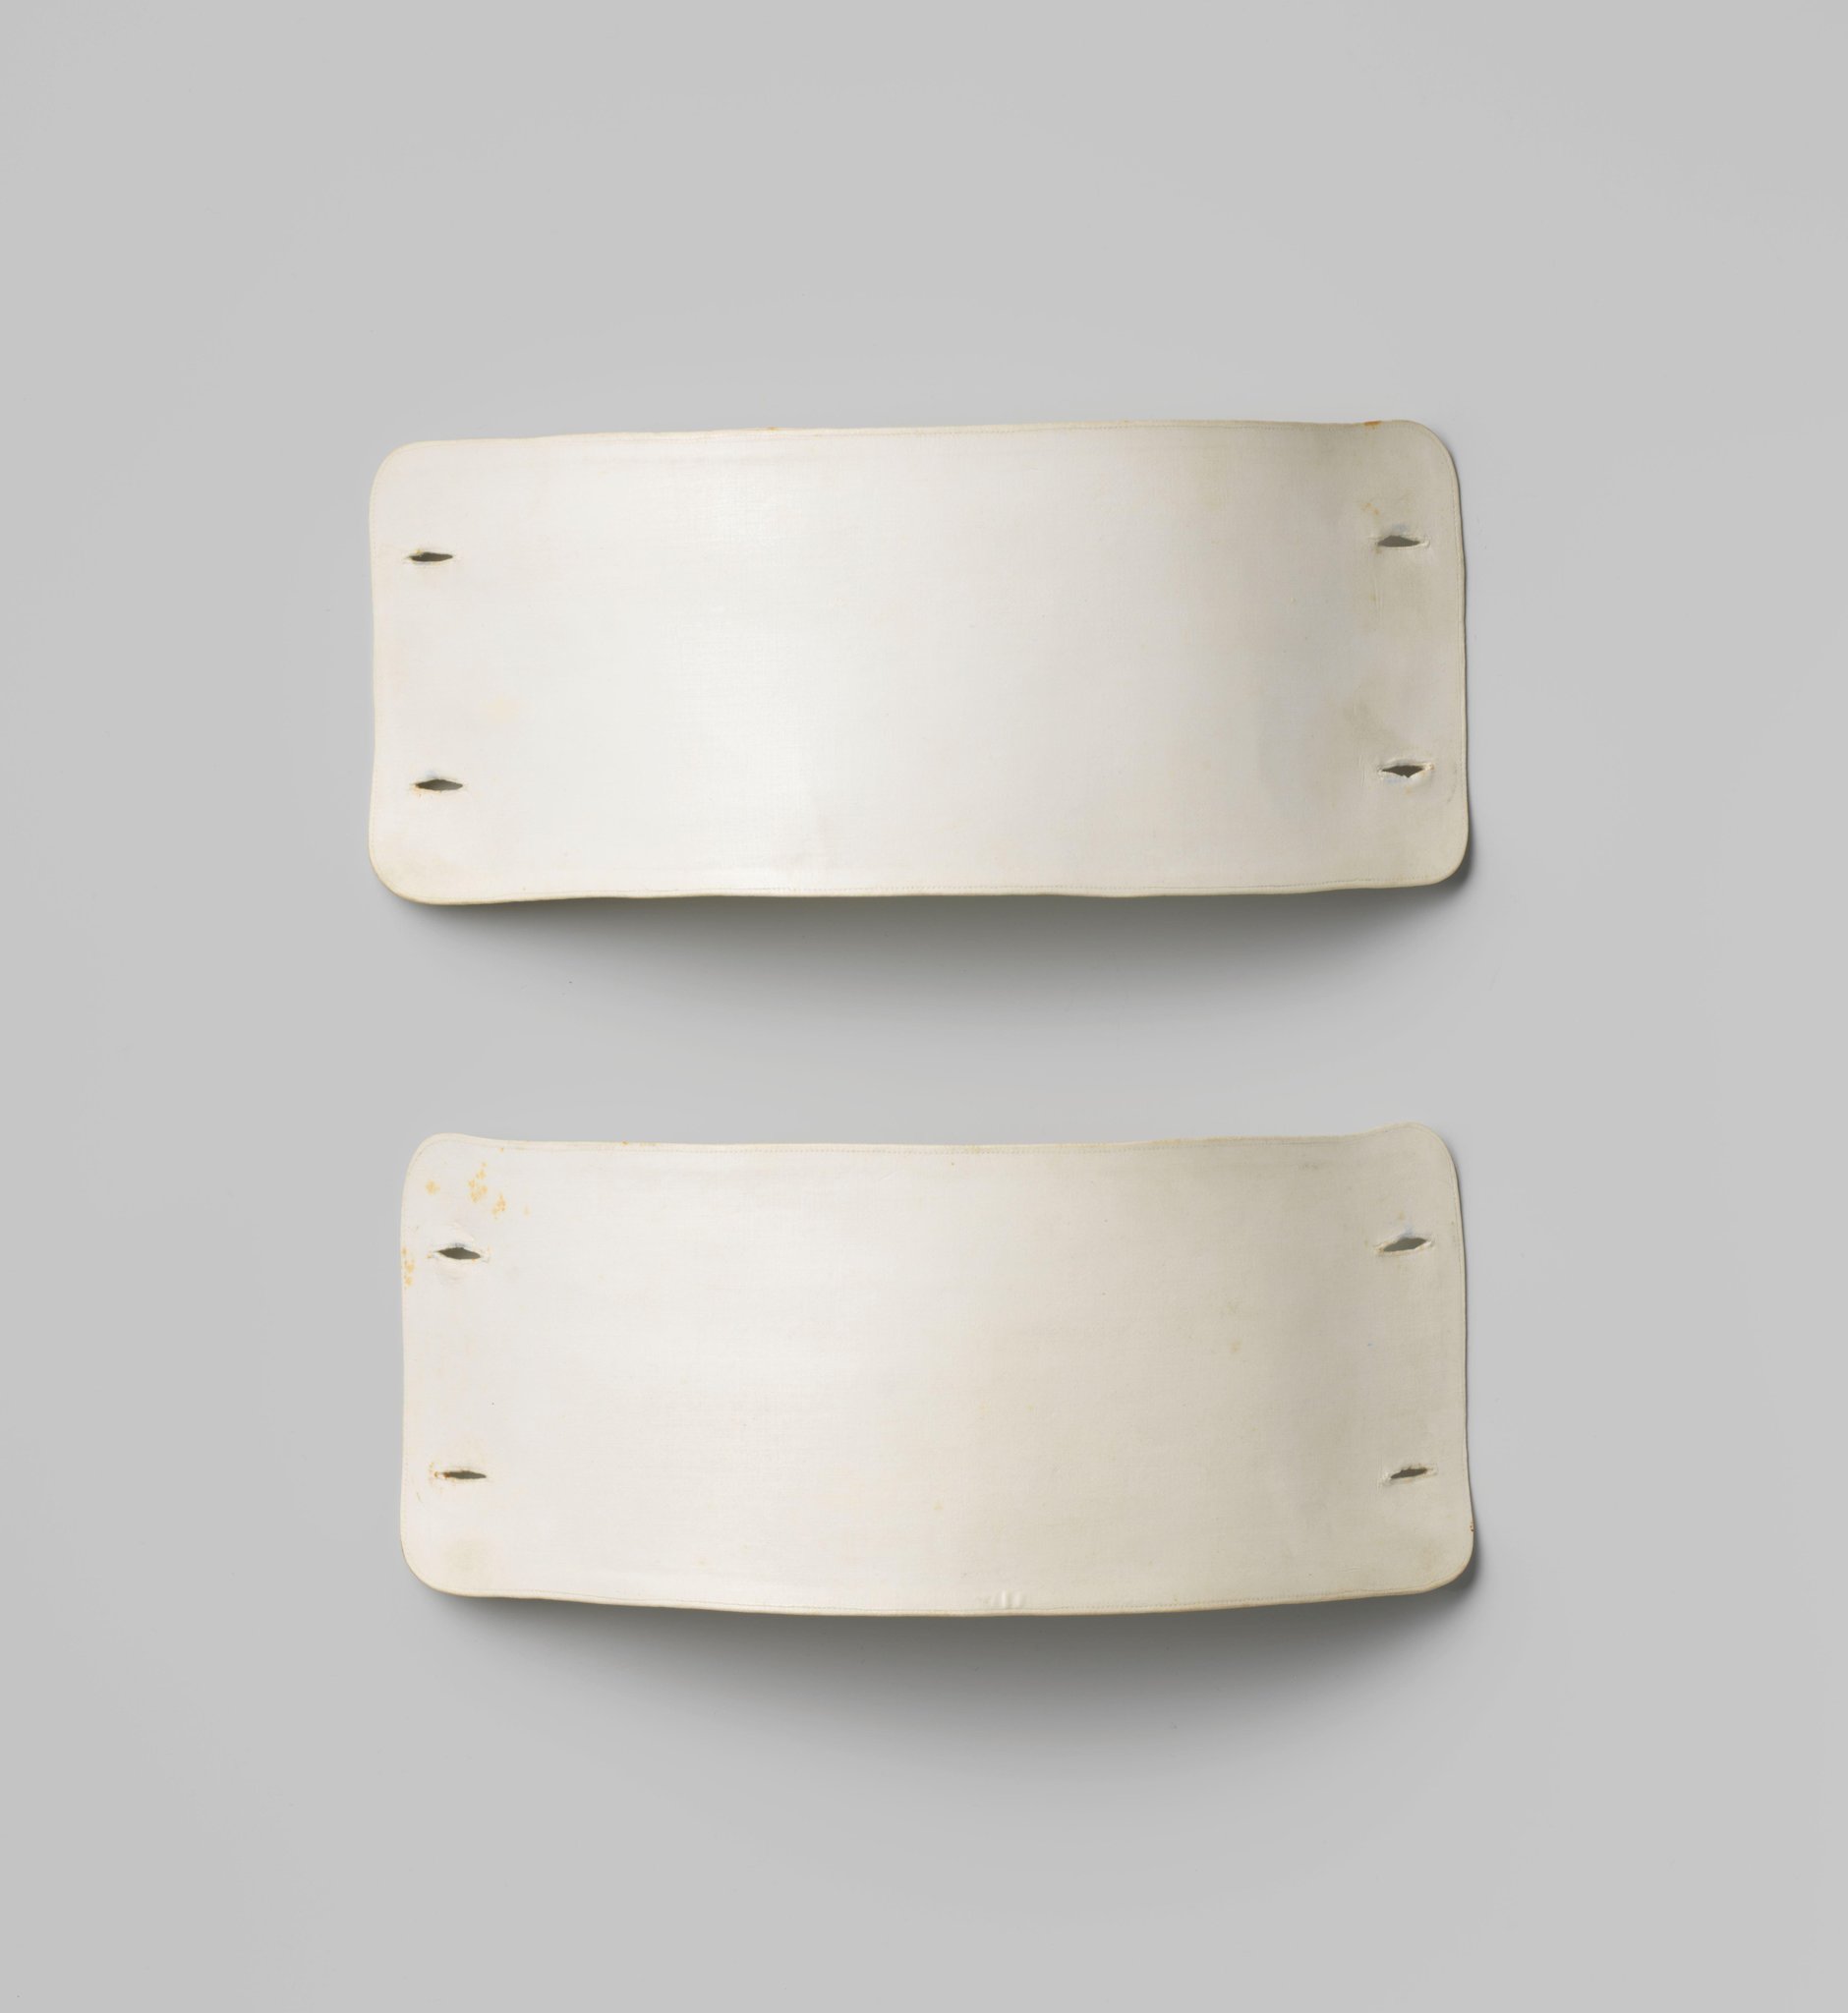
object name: cuff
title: Manchet van ambtskostuum van burgemeester Hoytema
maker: Anonymous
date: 1800-1923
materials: textile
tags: c.p. hoytema van konijnenburg, scherpenzeel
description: Kostuum is gedragen door hem als burgemeester van Scherpenzeel en daarvoor door zijn vader als burgemeester van Bergambacht, Enkhuizen en Naarden